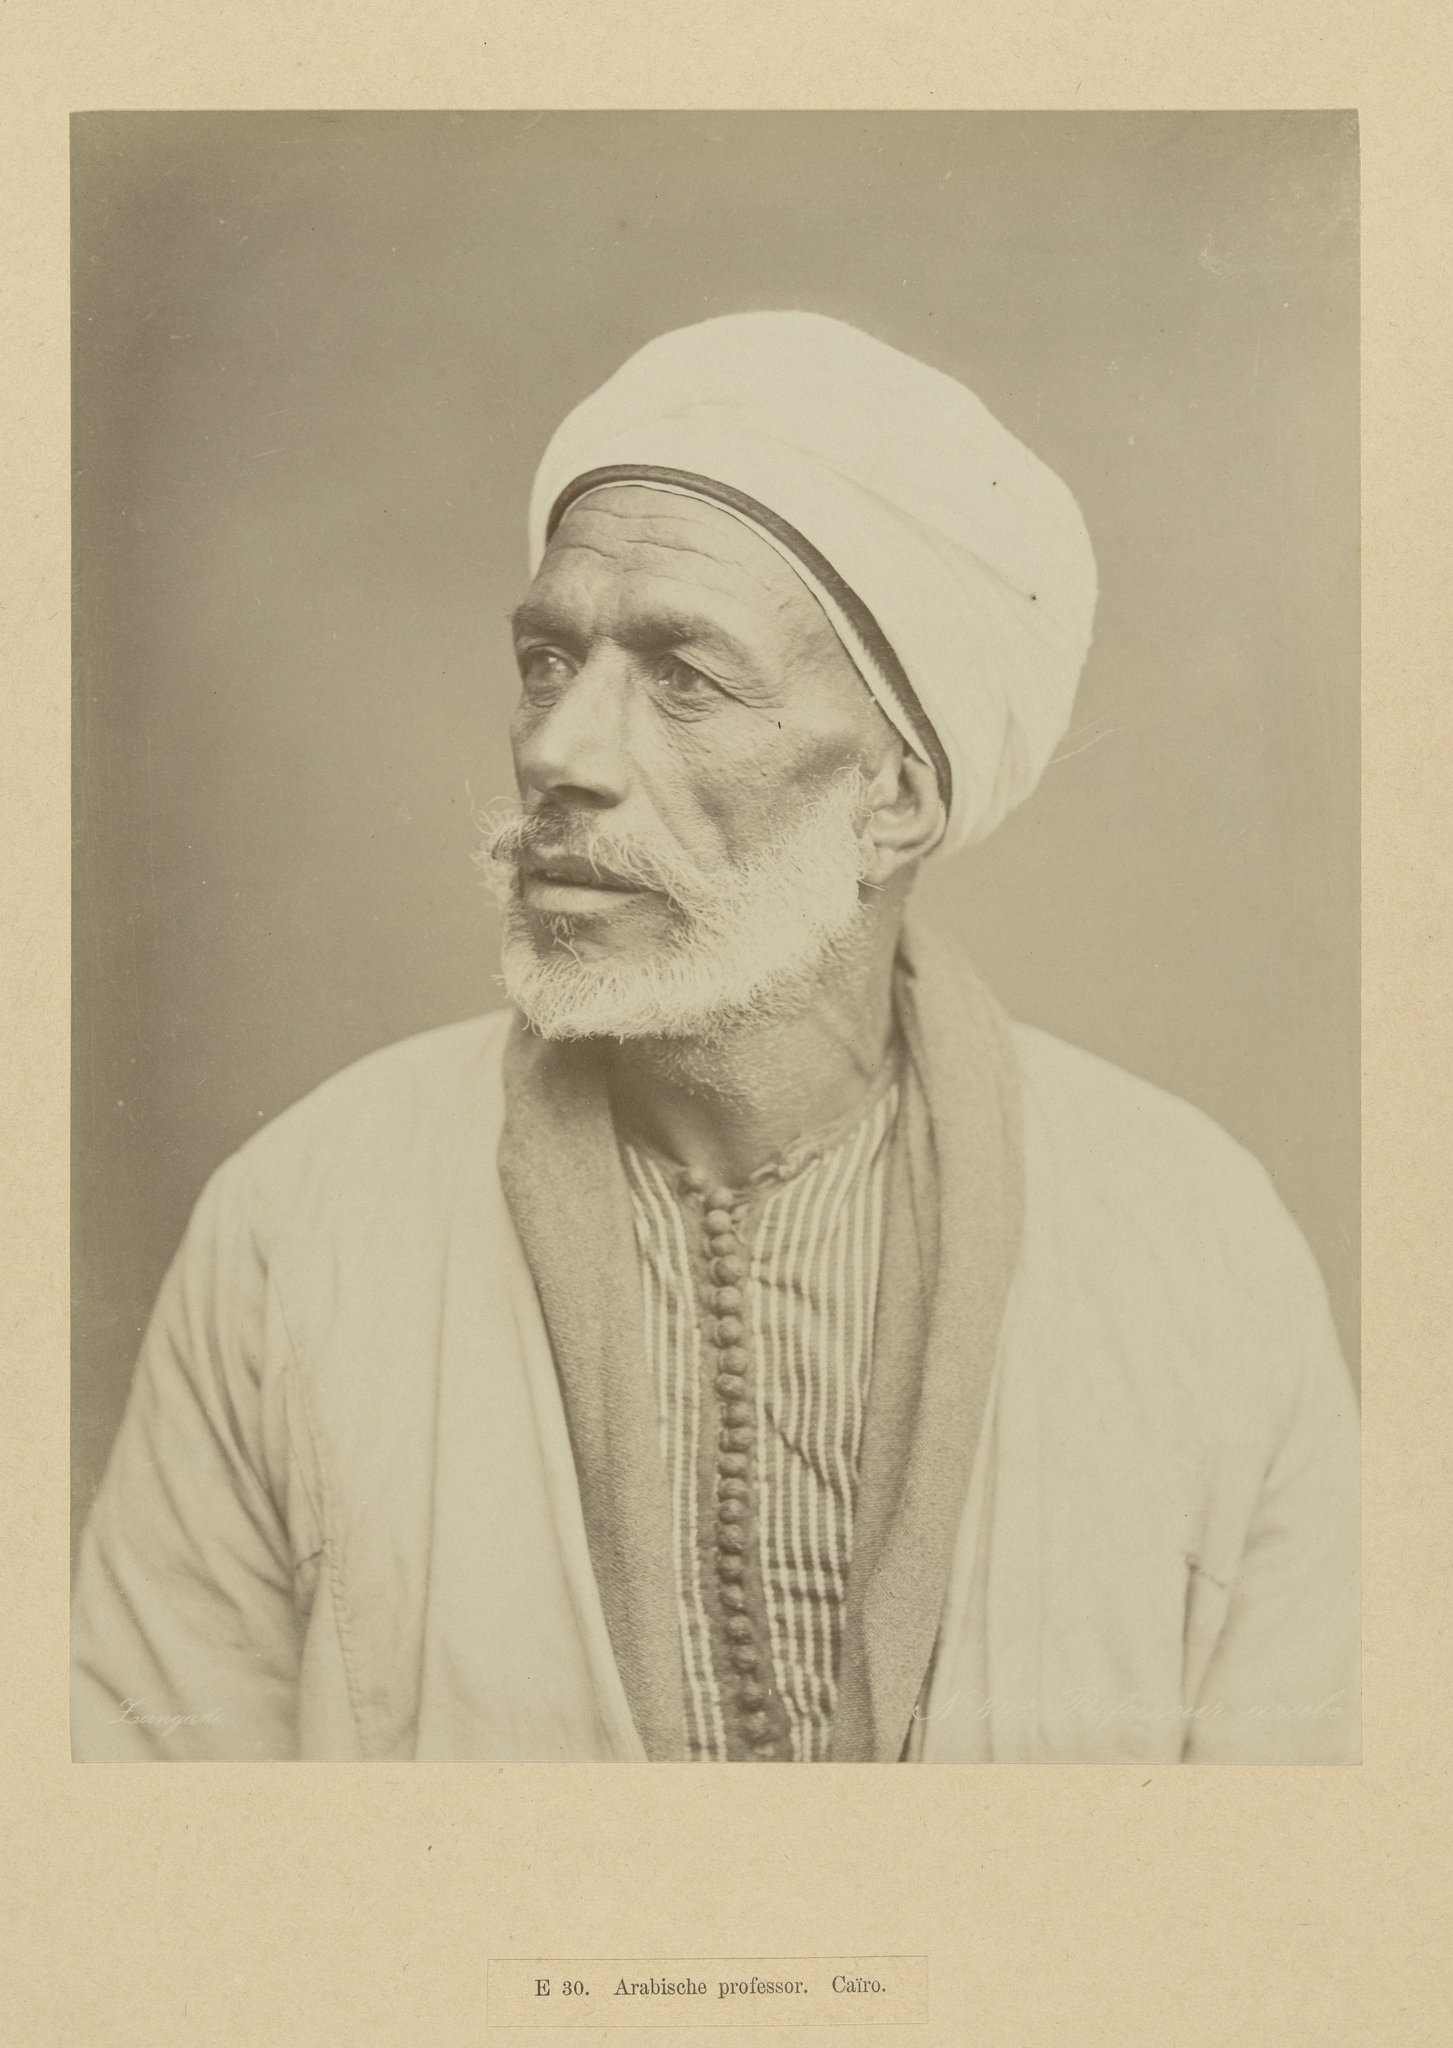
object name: photograph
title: Portret van een onbekende professor, Caïro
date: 1870-1895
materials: cardboard, paper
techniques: albumen print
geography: cairo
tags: professor, historical persons not known by name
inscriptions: number: ‘N 803’, title: ‘E 30. Arabische professor. Caïro.’, check stamp: ‘Bristol/ L.M.’, stamp: ‘Gemeentelijke bibliotheek/ Rotterdam’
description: Onderdeel van een groep door fotograaf Richard Polak op reis verzamelde foto’s. Deze foto is samen met andere op zijn reizen verzamelde foto's tentoongesteld bij de Rotterdamsche Kunstkring (1895), Arti en Amicitiae te Amsterdam (1897-1898?) en Societeit 't Collegie te Kampen (datum vooralsnog onbekend).